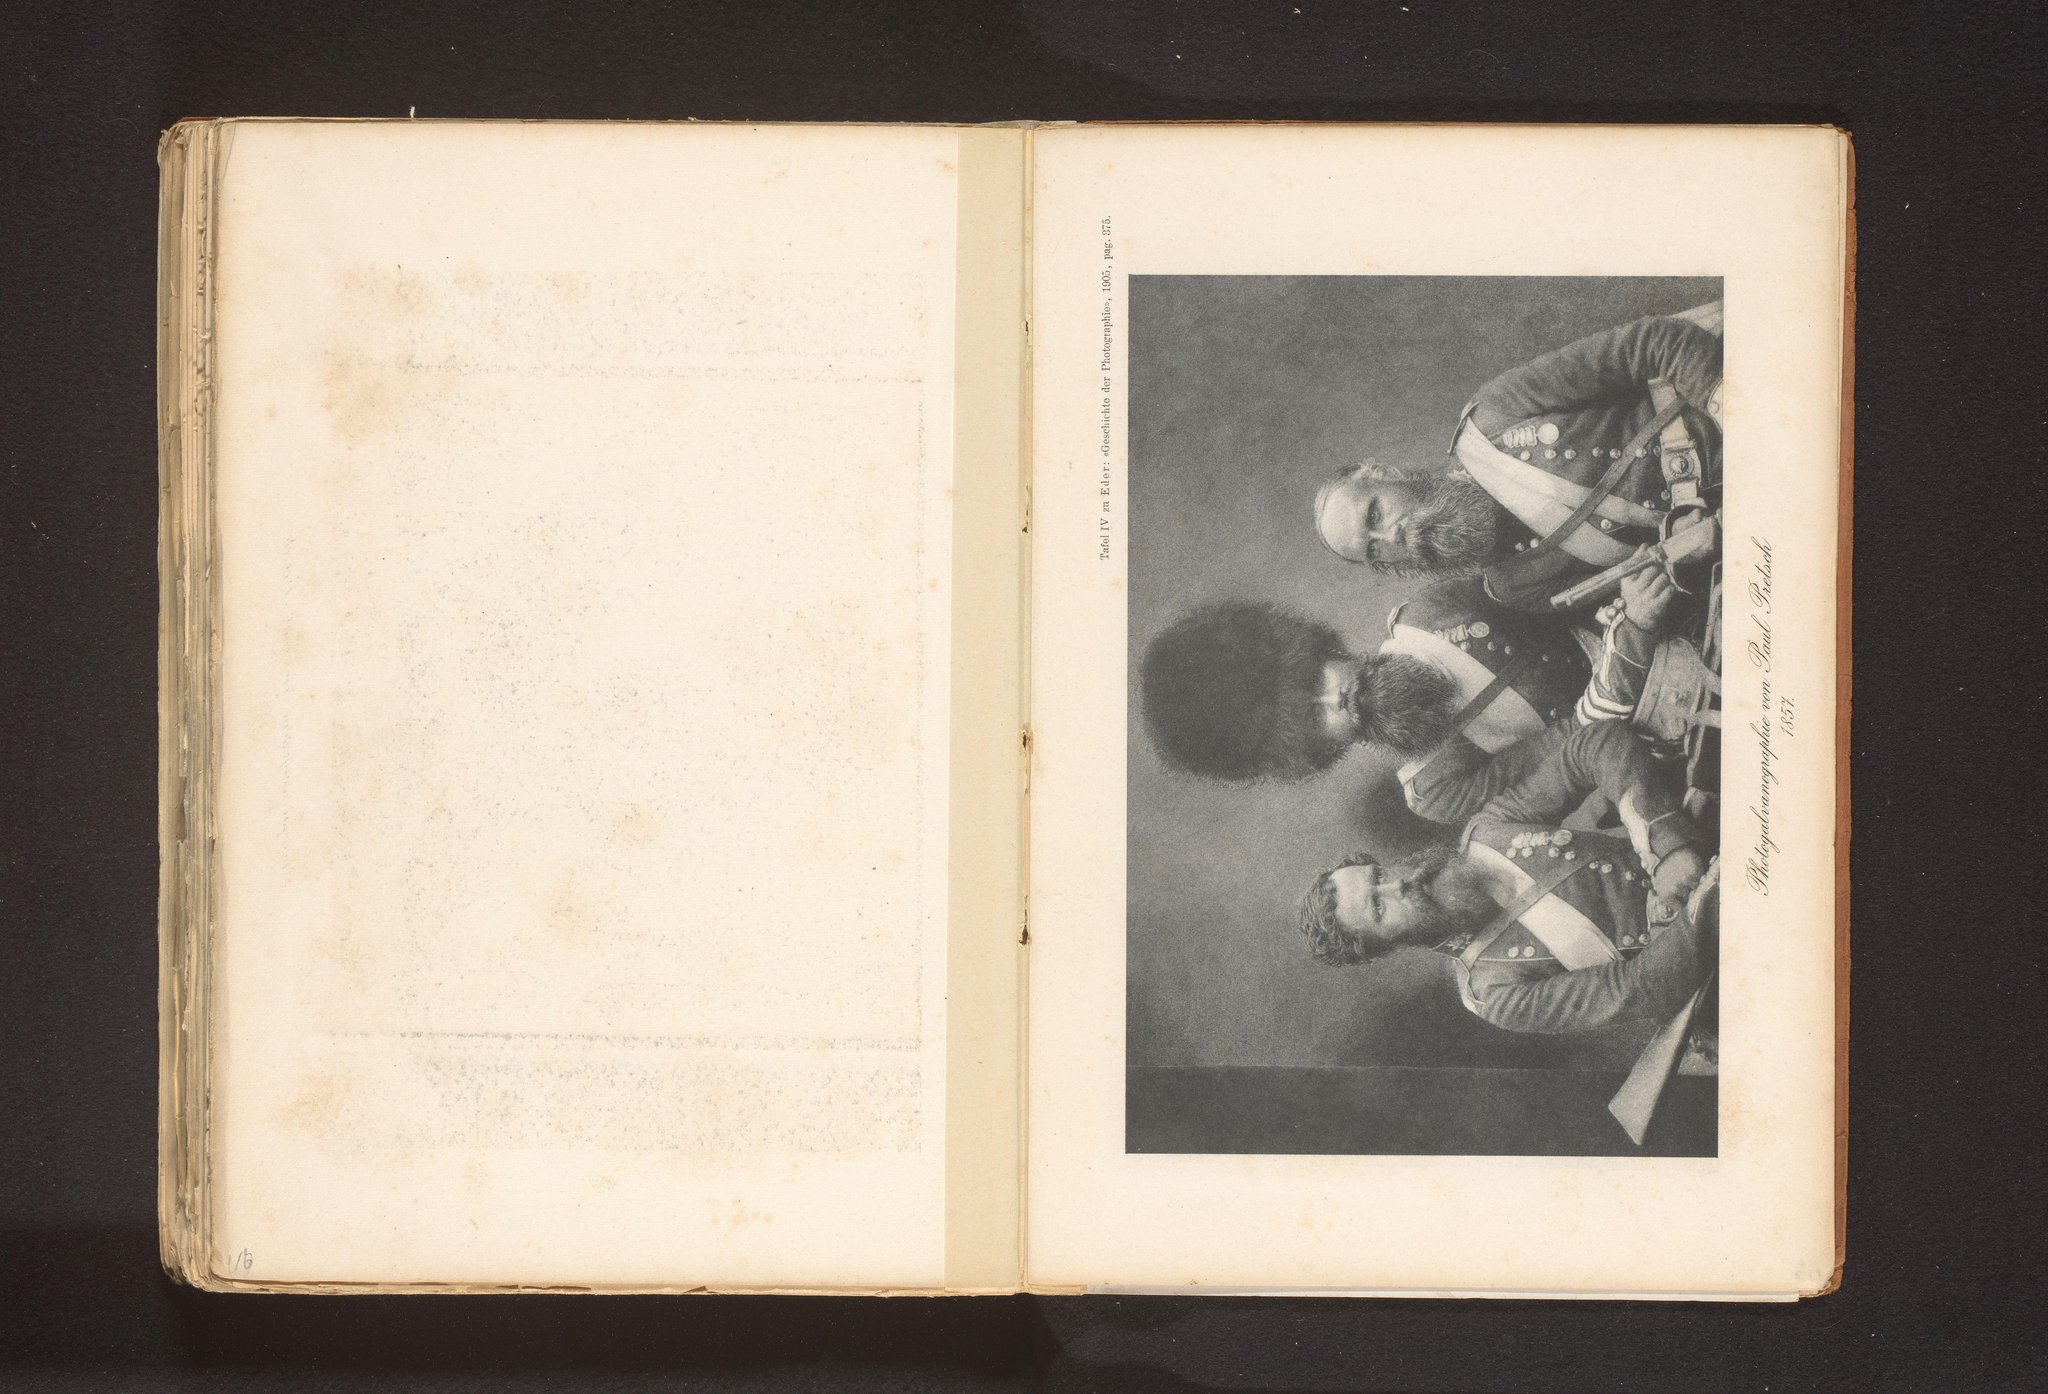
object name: photomechanical print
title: Portret van drie onbekende mannen in uniform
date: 1900-1905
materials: paper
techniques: photogalvanography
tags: adult man, (military) uniforms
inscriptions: number: ‘Tafel IV’